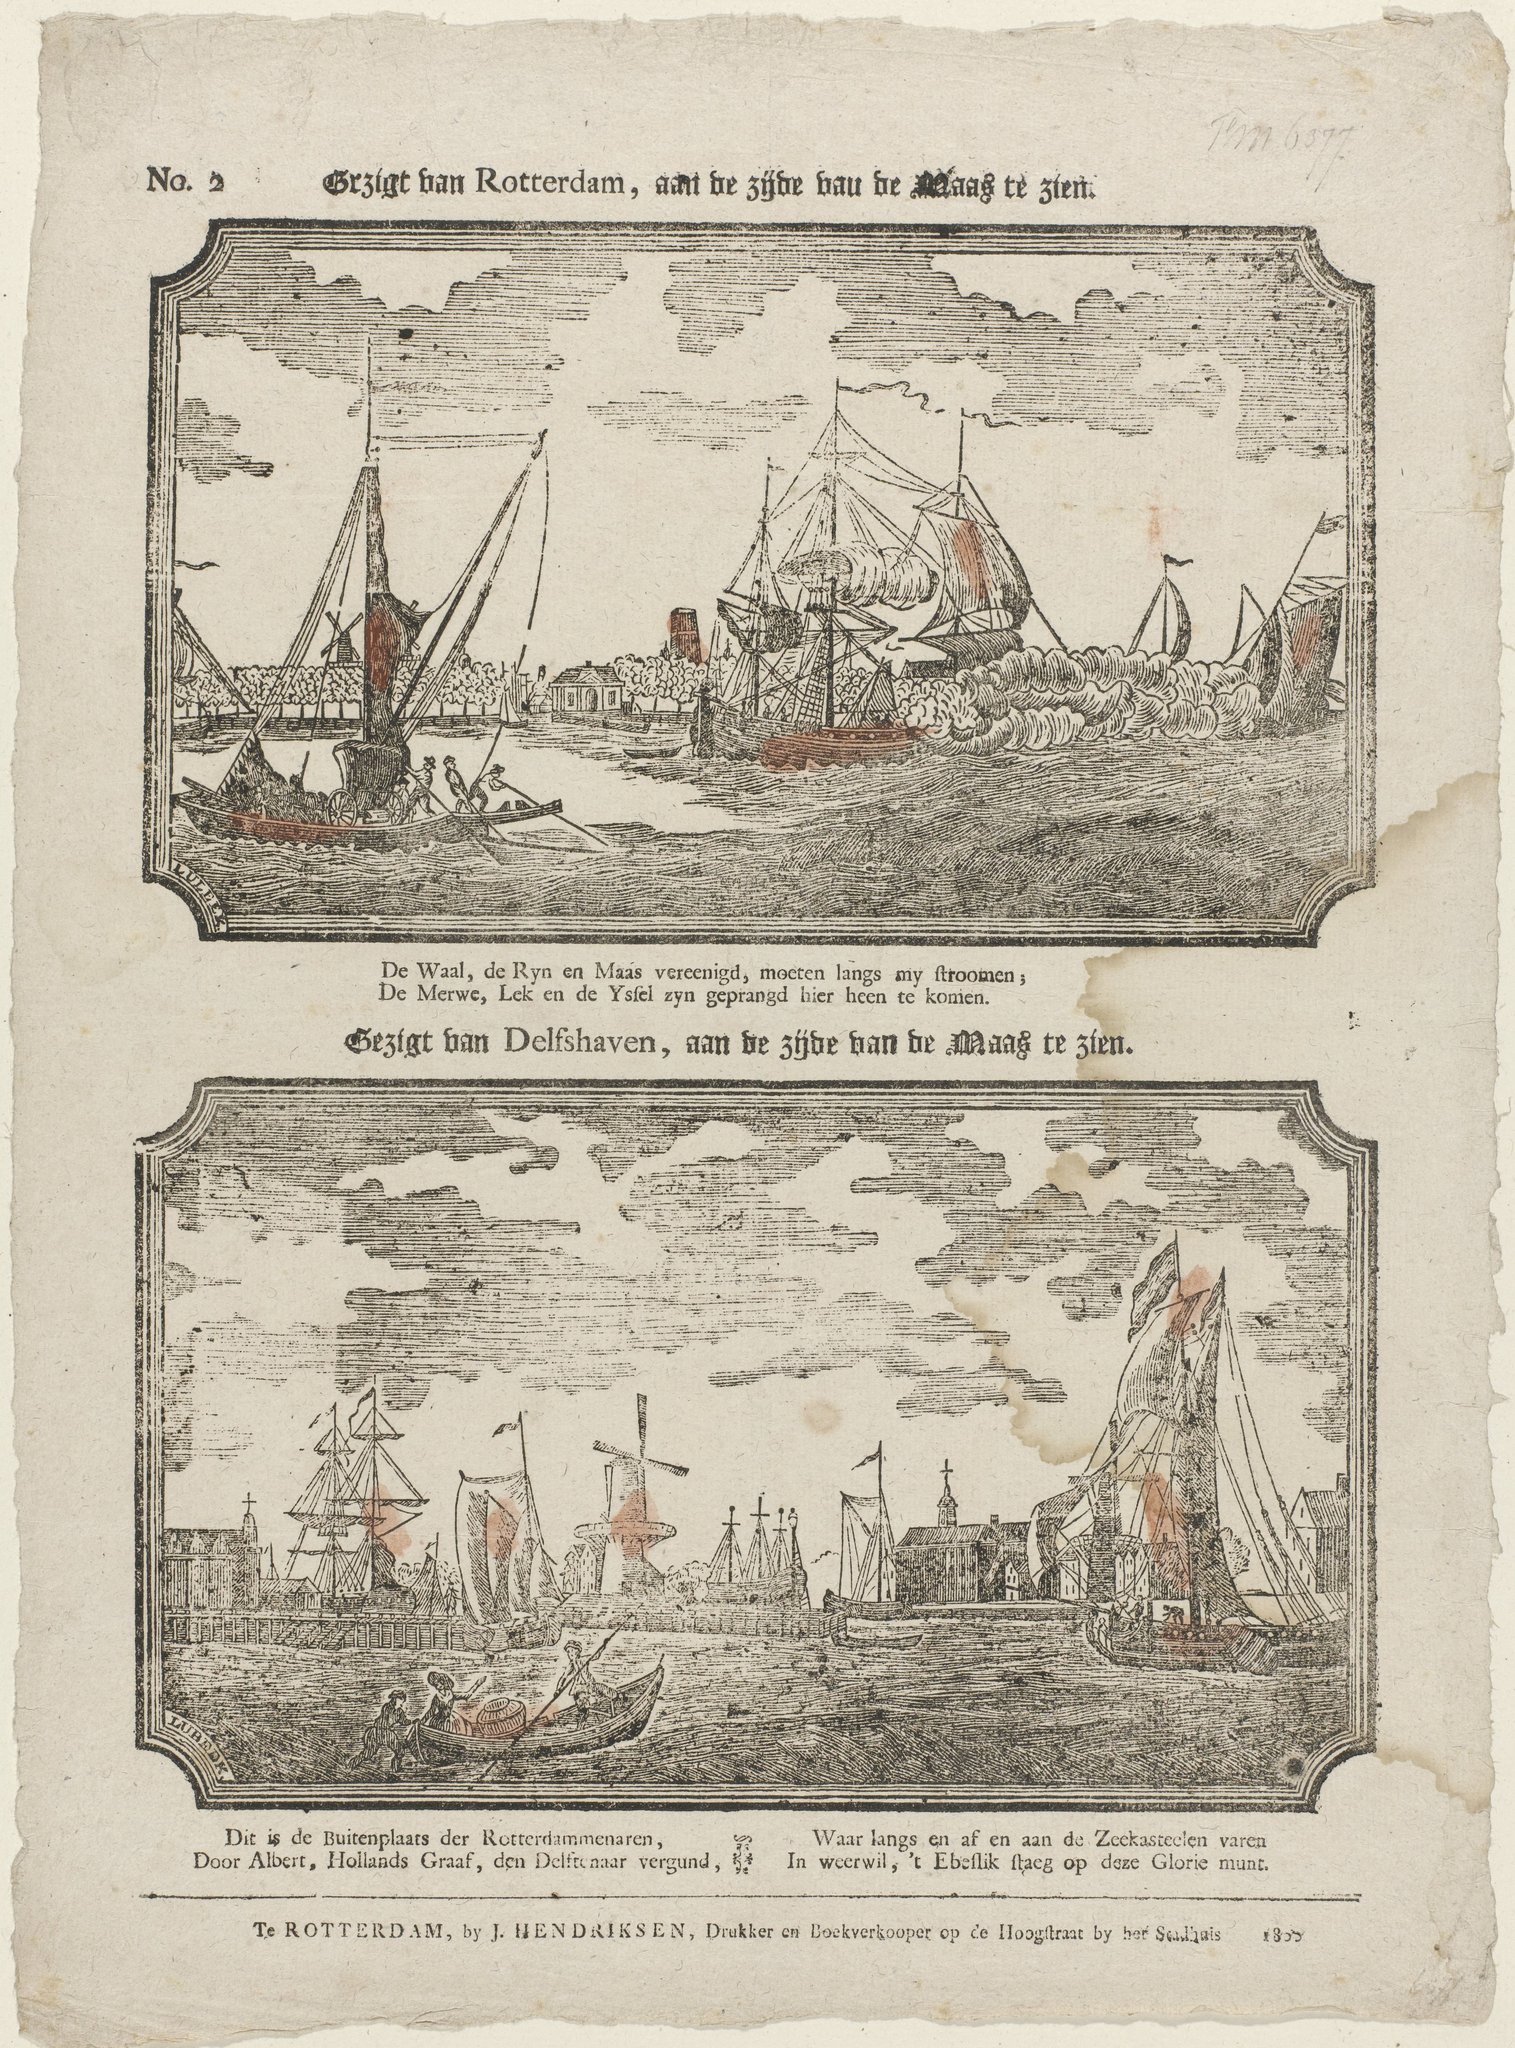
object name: print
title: Gezigt van Rotterdam, aan de zijde van de Maas te zien / Gezigt van Delfshaven, aan de zijde van de Maas te zien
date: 1805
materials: paper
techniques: colour, letterpress printing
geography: rotterdam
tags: river, ships (in general), delfshaven, rotterdam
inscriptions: date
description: Blad met 2 voorstellingen. Boven: een gezicht op Rotterdam vanaf de Maas gezien. Onder: een gezicht op Delfshaven vanaf de Maas gezien. Onder de afbeeldingen een onderschrift. Genummerd linksboven: No. 2.